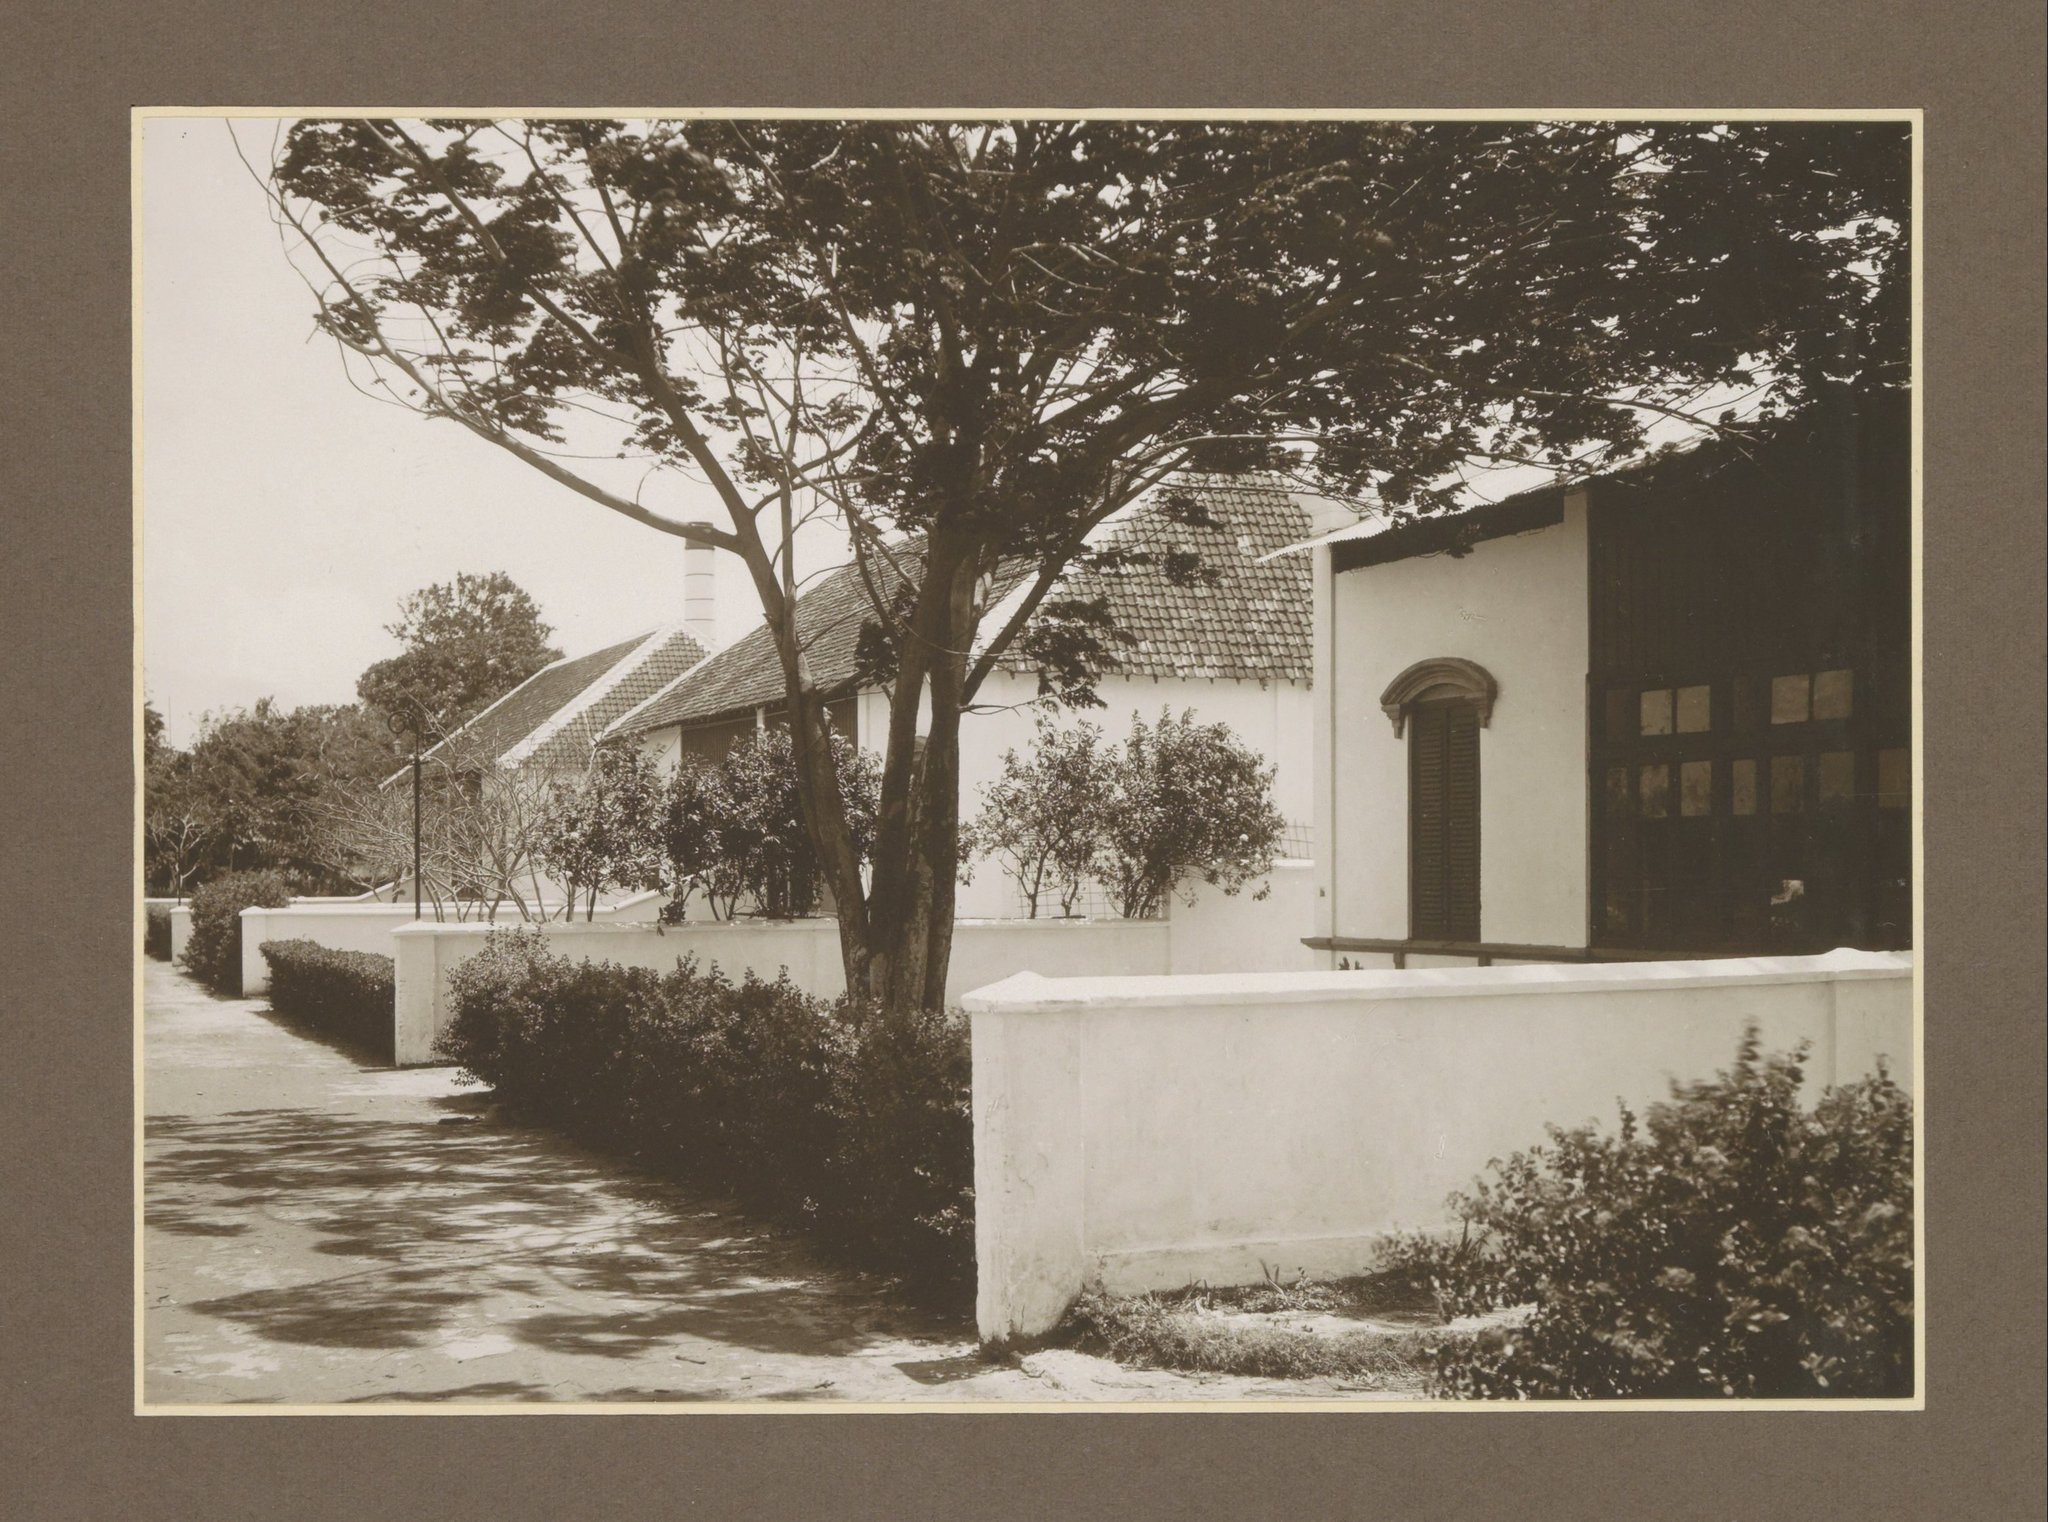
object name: photograph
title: Sf. Meritjan Emploijeswoningen, 2e klasse tijpe, aan de Brantas gelegen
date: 1925-1930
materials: cardboard, paper, photographic support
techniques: gelatin silver print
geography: kediri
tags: plantation, rural housing, e.g. country-house, villa, cottage, plants and herbs: sugarcane, sugar, dutch east indies, the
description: Onderdeel van Fotoalbum met opnames van vier suikerfabrieken op Java.